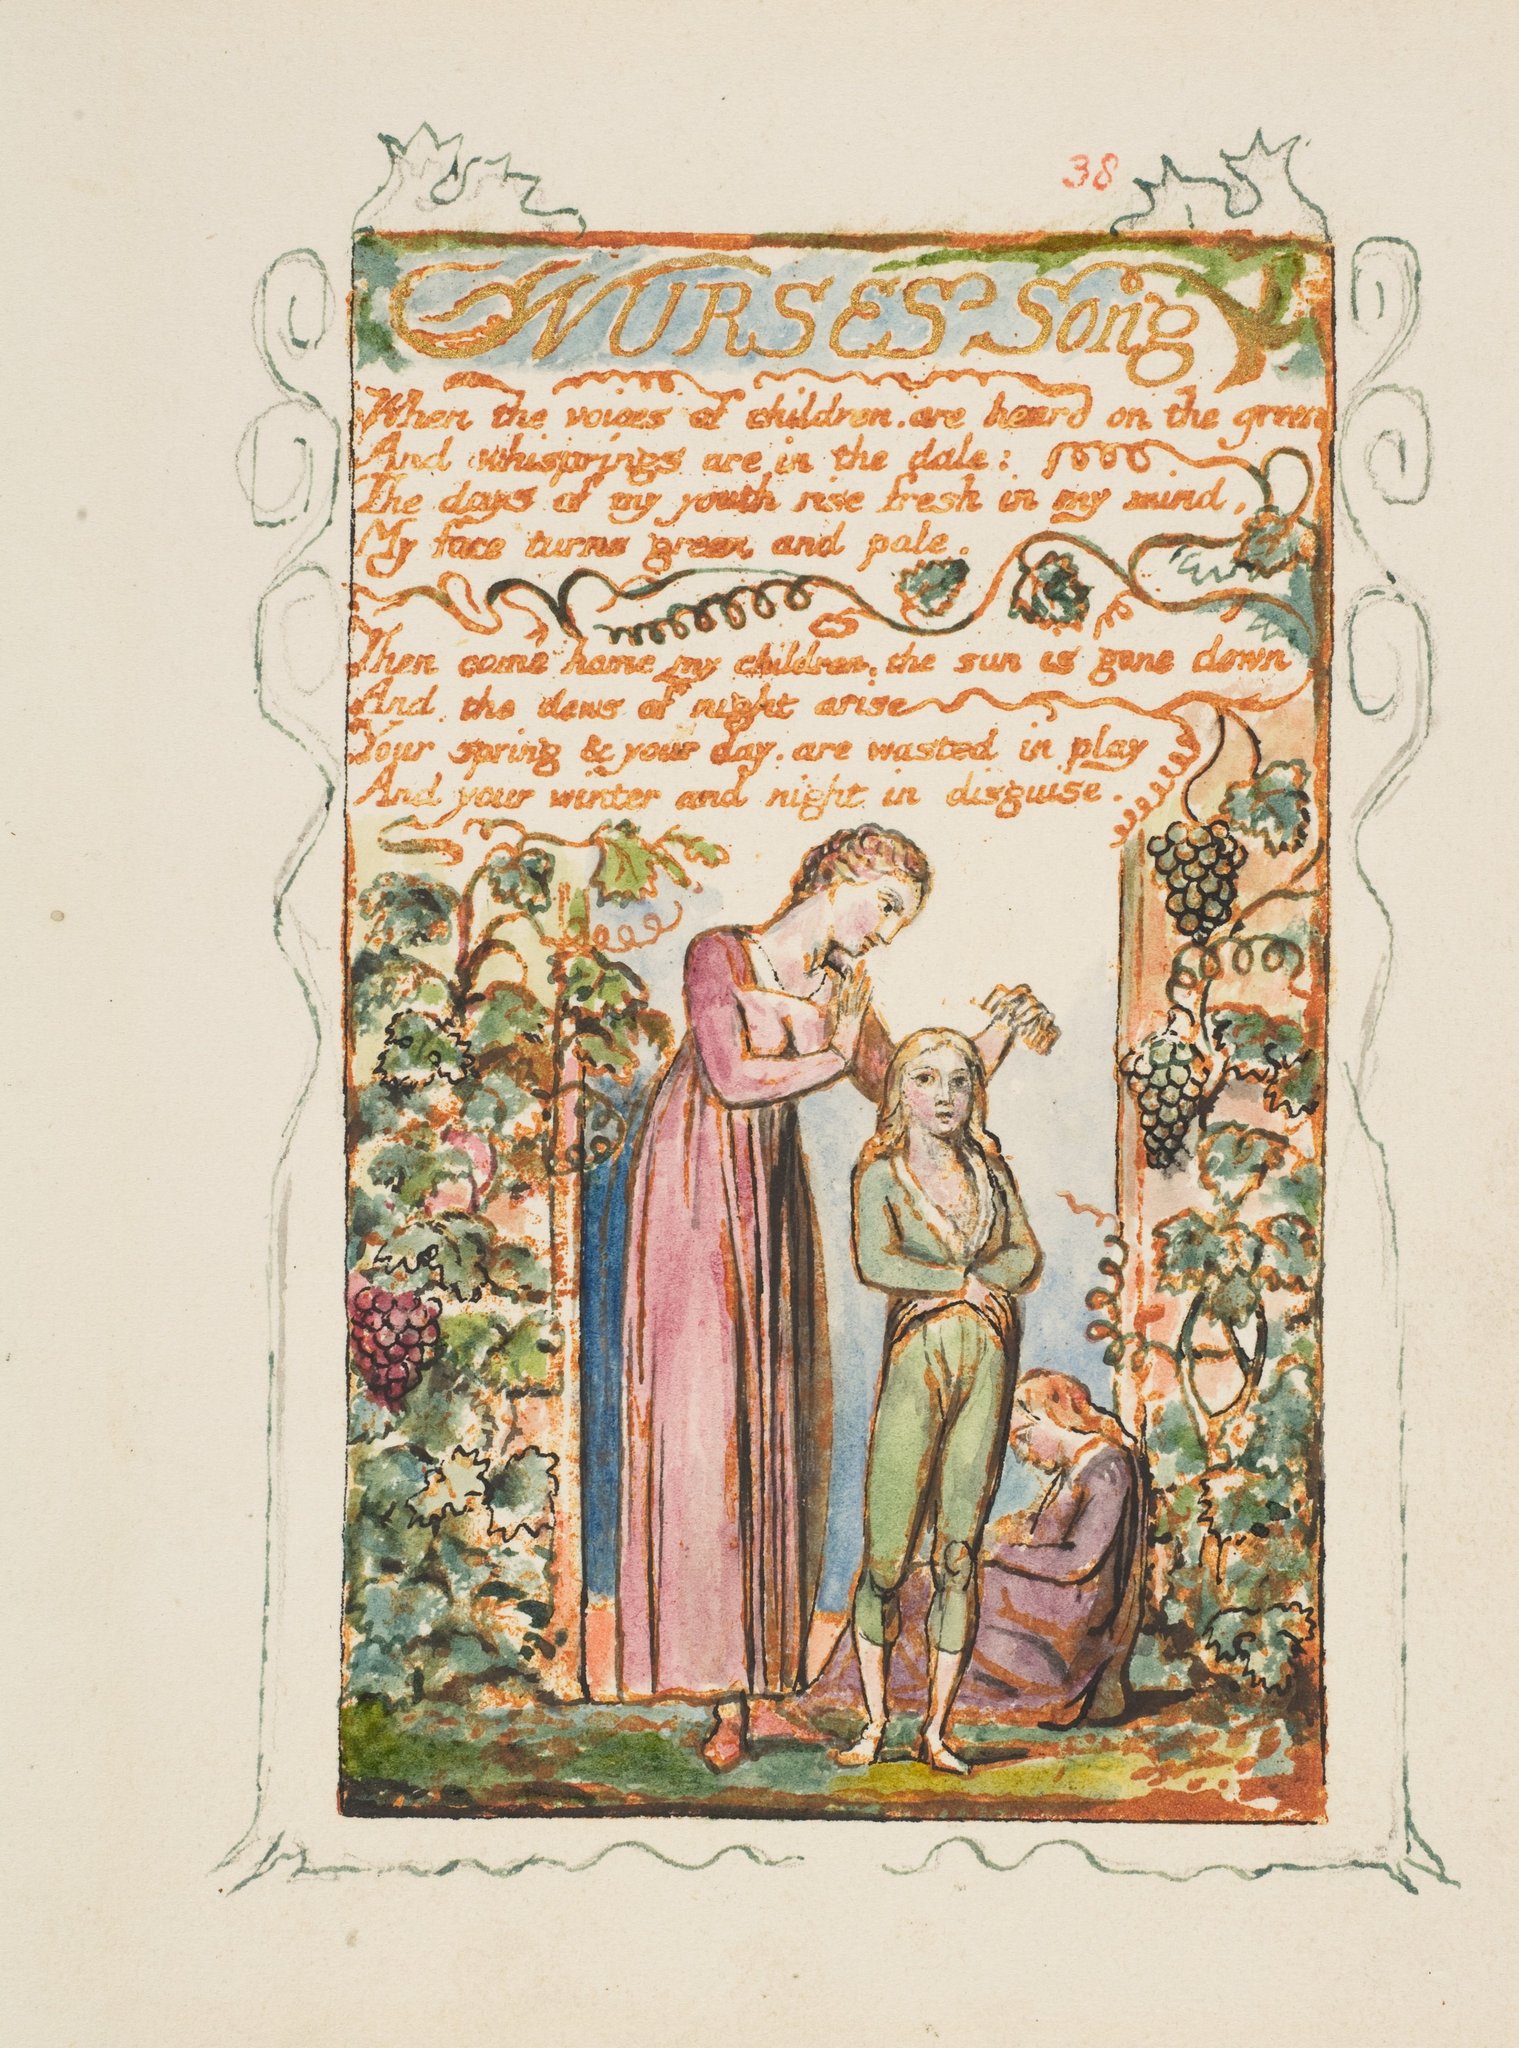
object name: print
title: Songs of Experience: Nurses Song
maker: william blake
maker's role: artist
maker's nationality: british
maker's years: 1757-1827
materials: gold, ink, shell, watercolor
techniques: etching, hand coloring, printing, relief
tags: fruit,girls,women,leaves